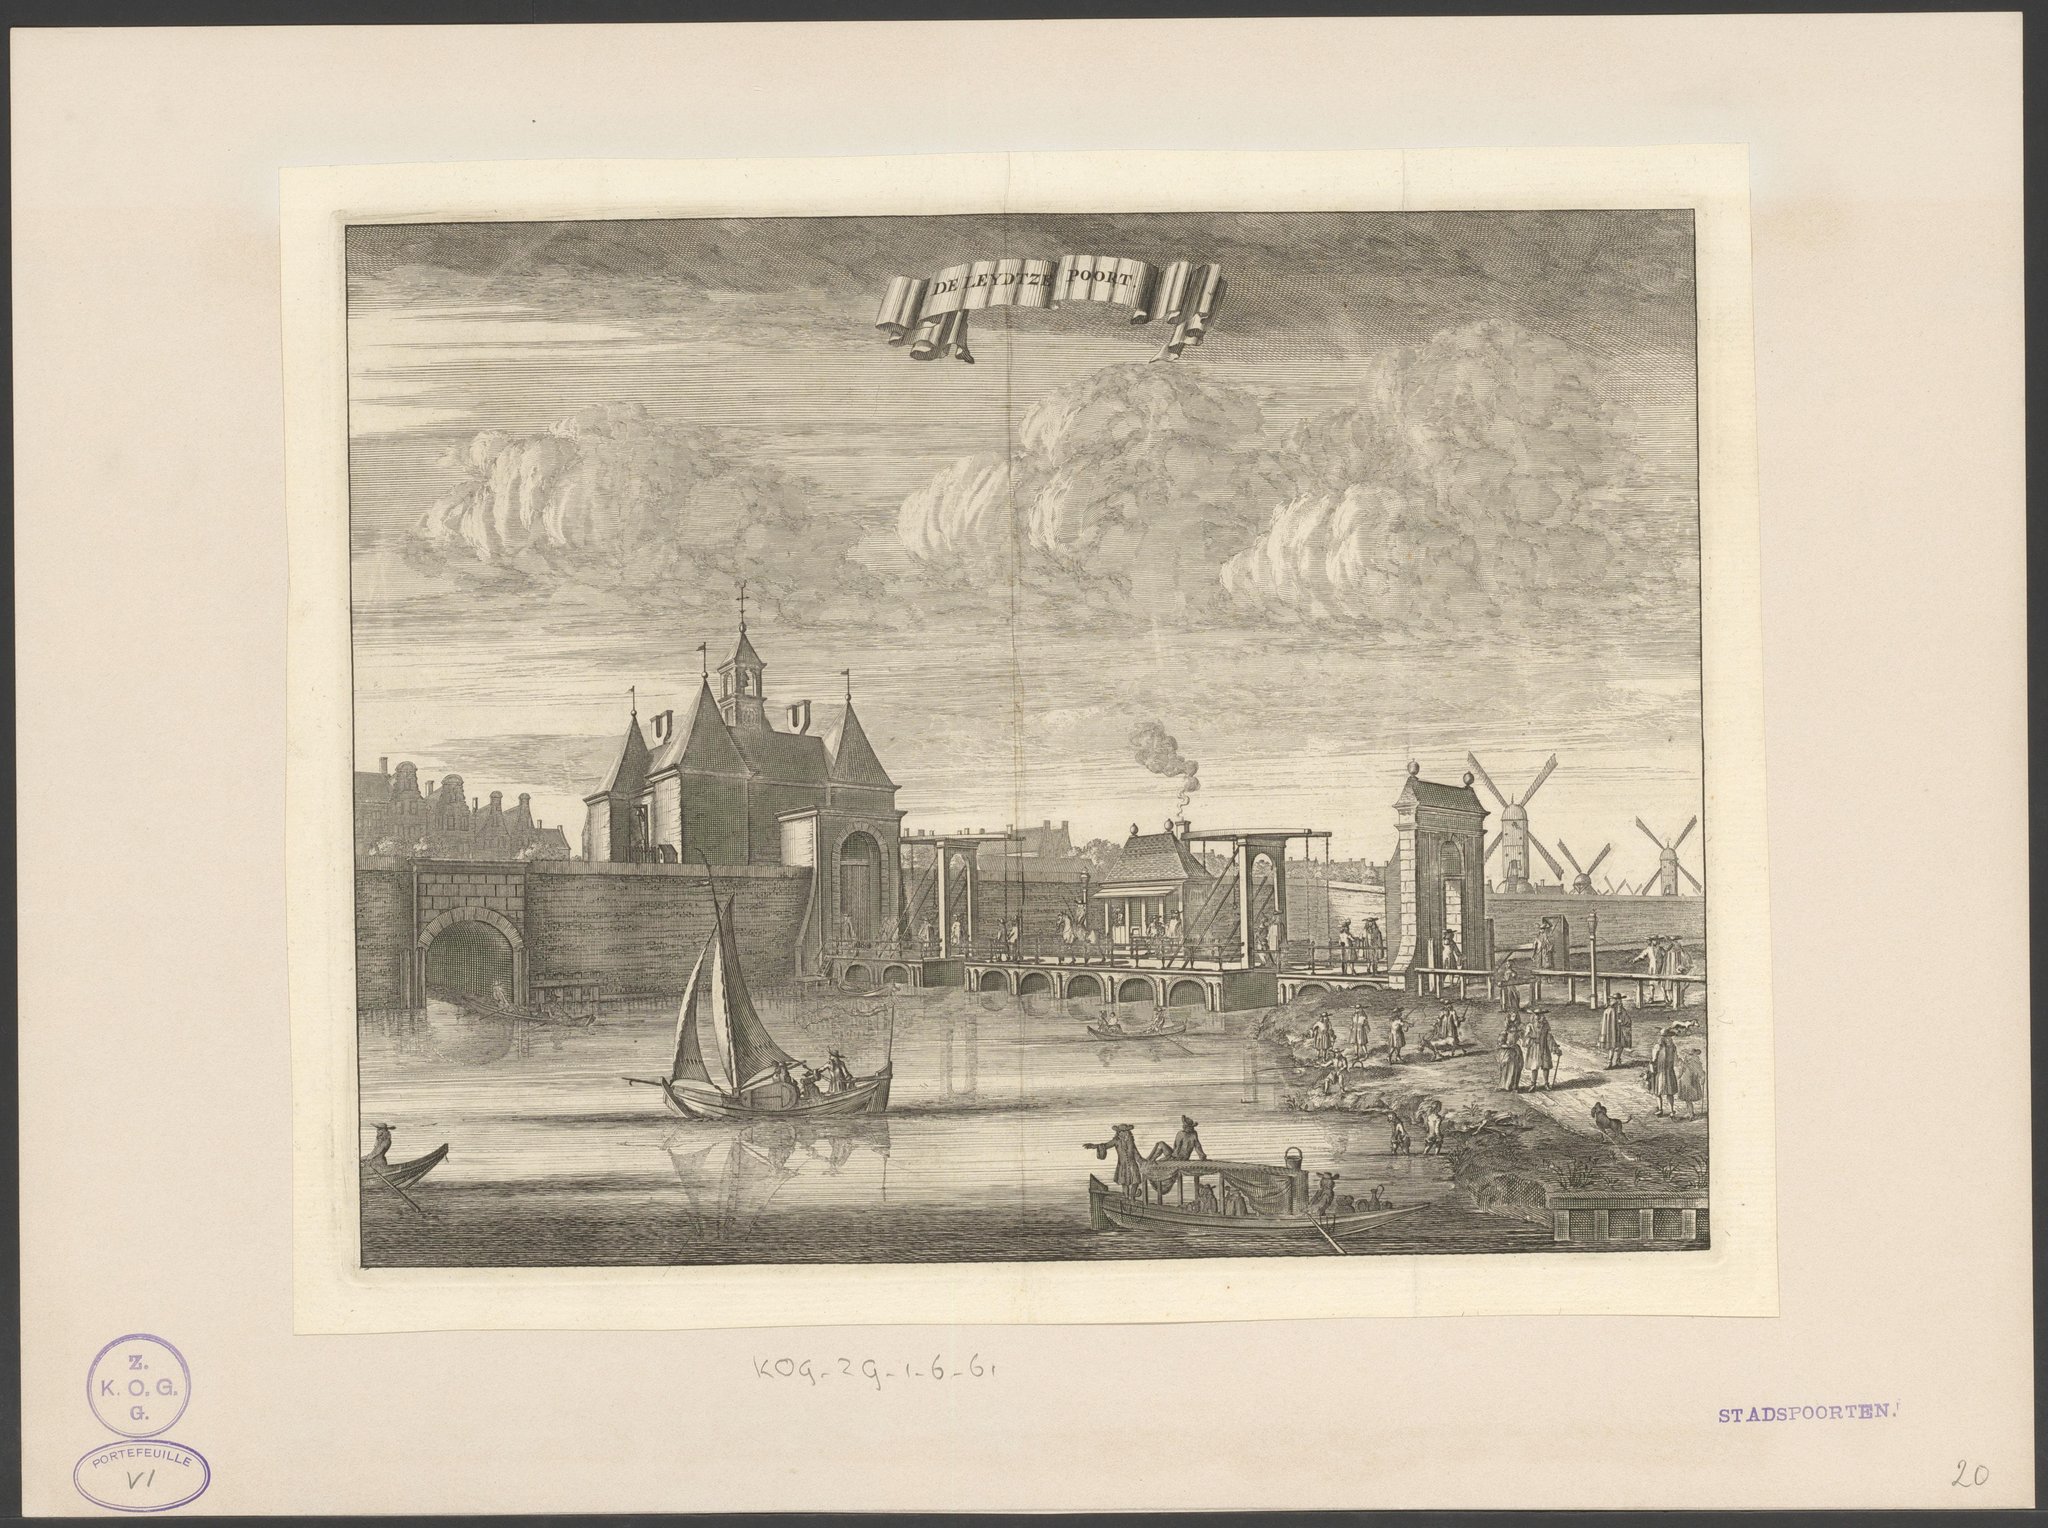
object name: print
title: Gezicht op de Leidsepoort in Amsterdam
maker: Anonymous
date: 1724-1726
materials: paper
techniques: engraving, etching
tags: canal, bridge, city-gate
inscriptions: stamp, stamp, collector's mark: Lugt 1641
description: Prent mogelijk uit: Commelin, Caspar. Beschryvinge van Amsterdam, zynde een naukeurige verhandelinge van desselfs eerste oorspronk uyt (…). 2 dln. 2de druk. Amsterdam: Andries van Damme et al., 1726.